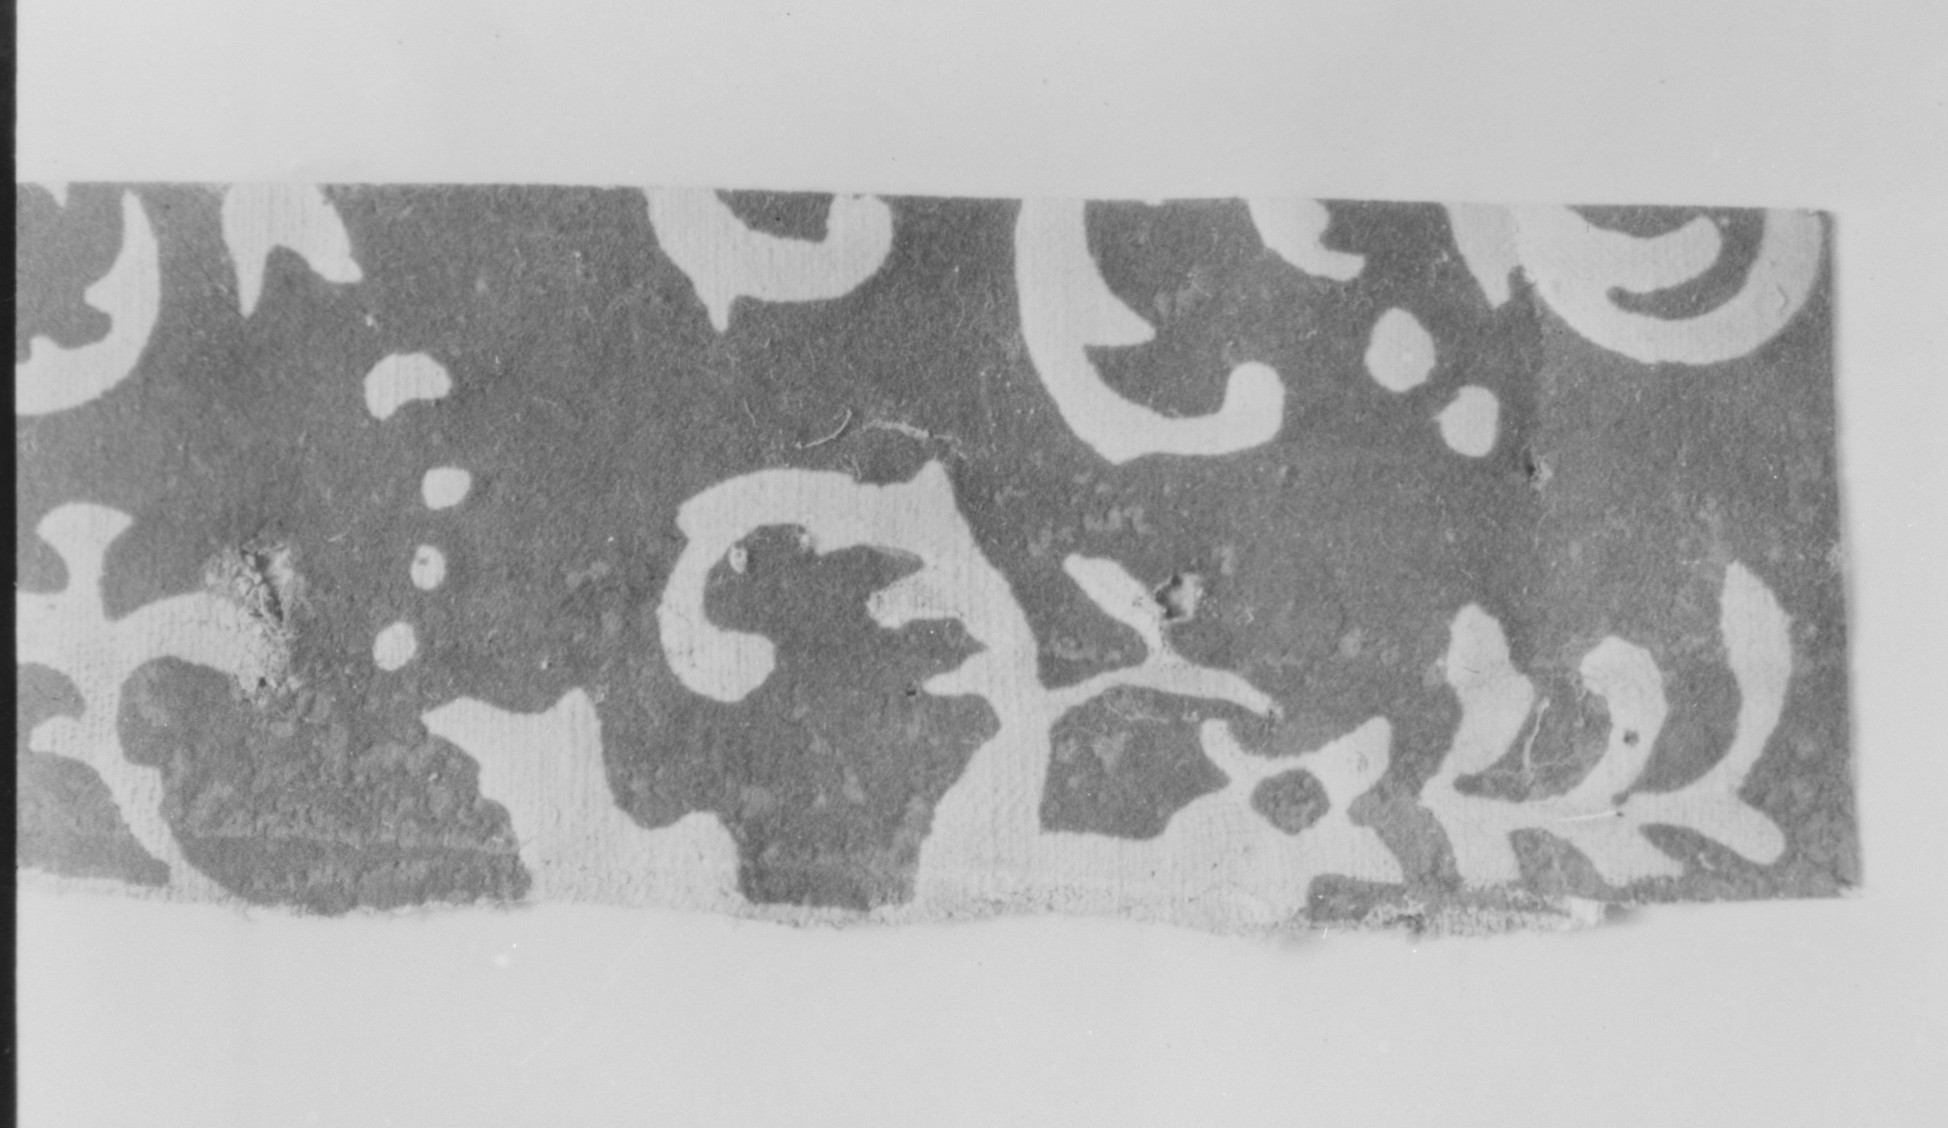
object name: wall covering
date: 1701-1800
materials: canvas, oil